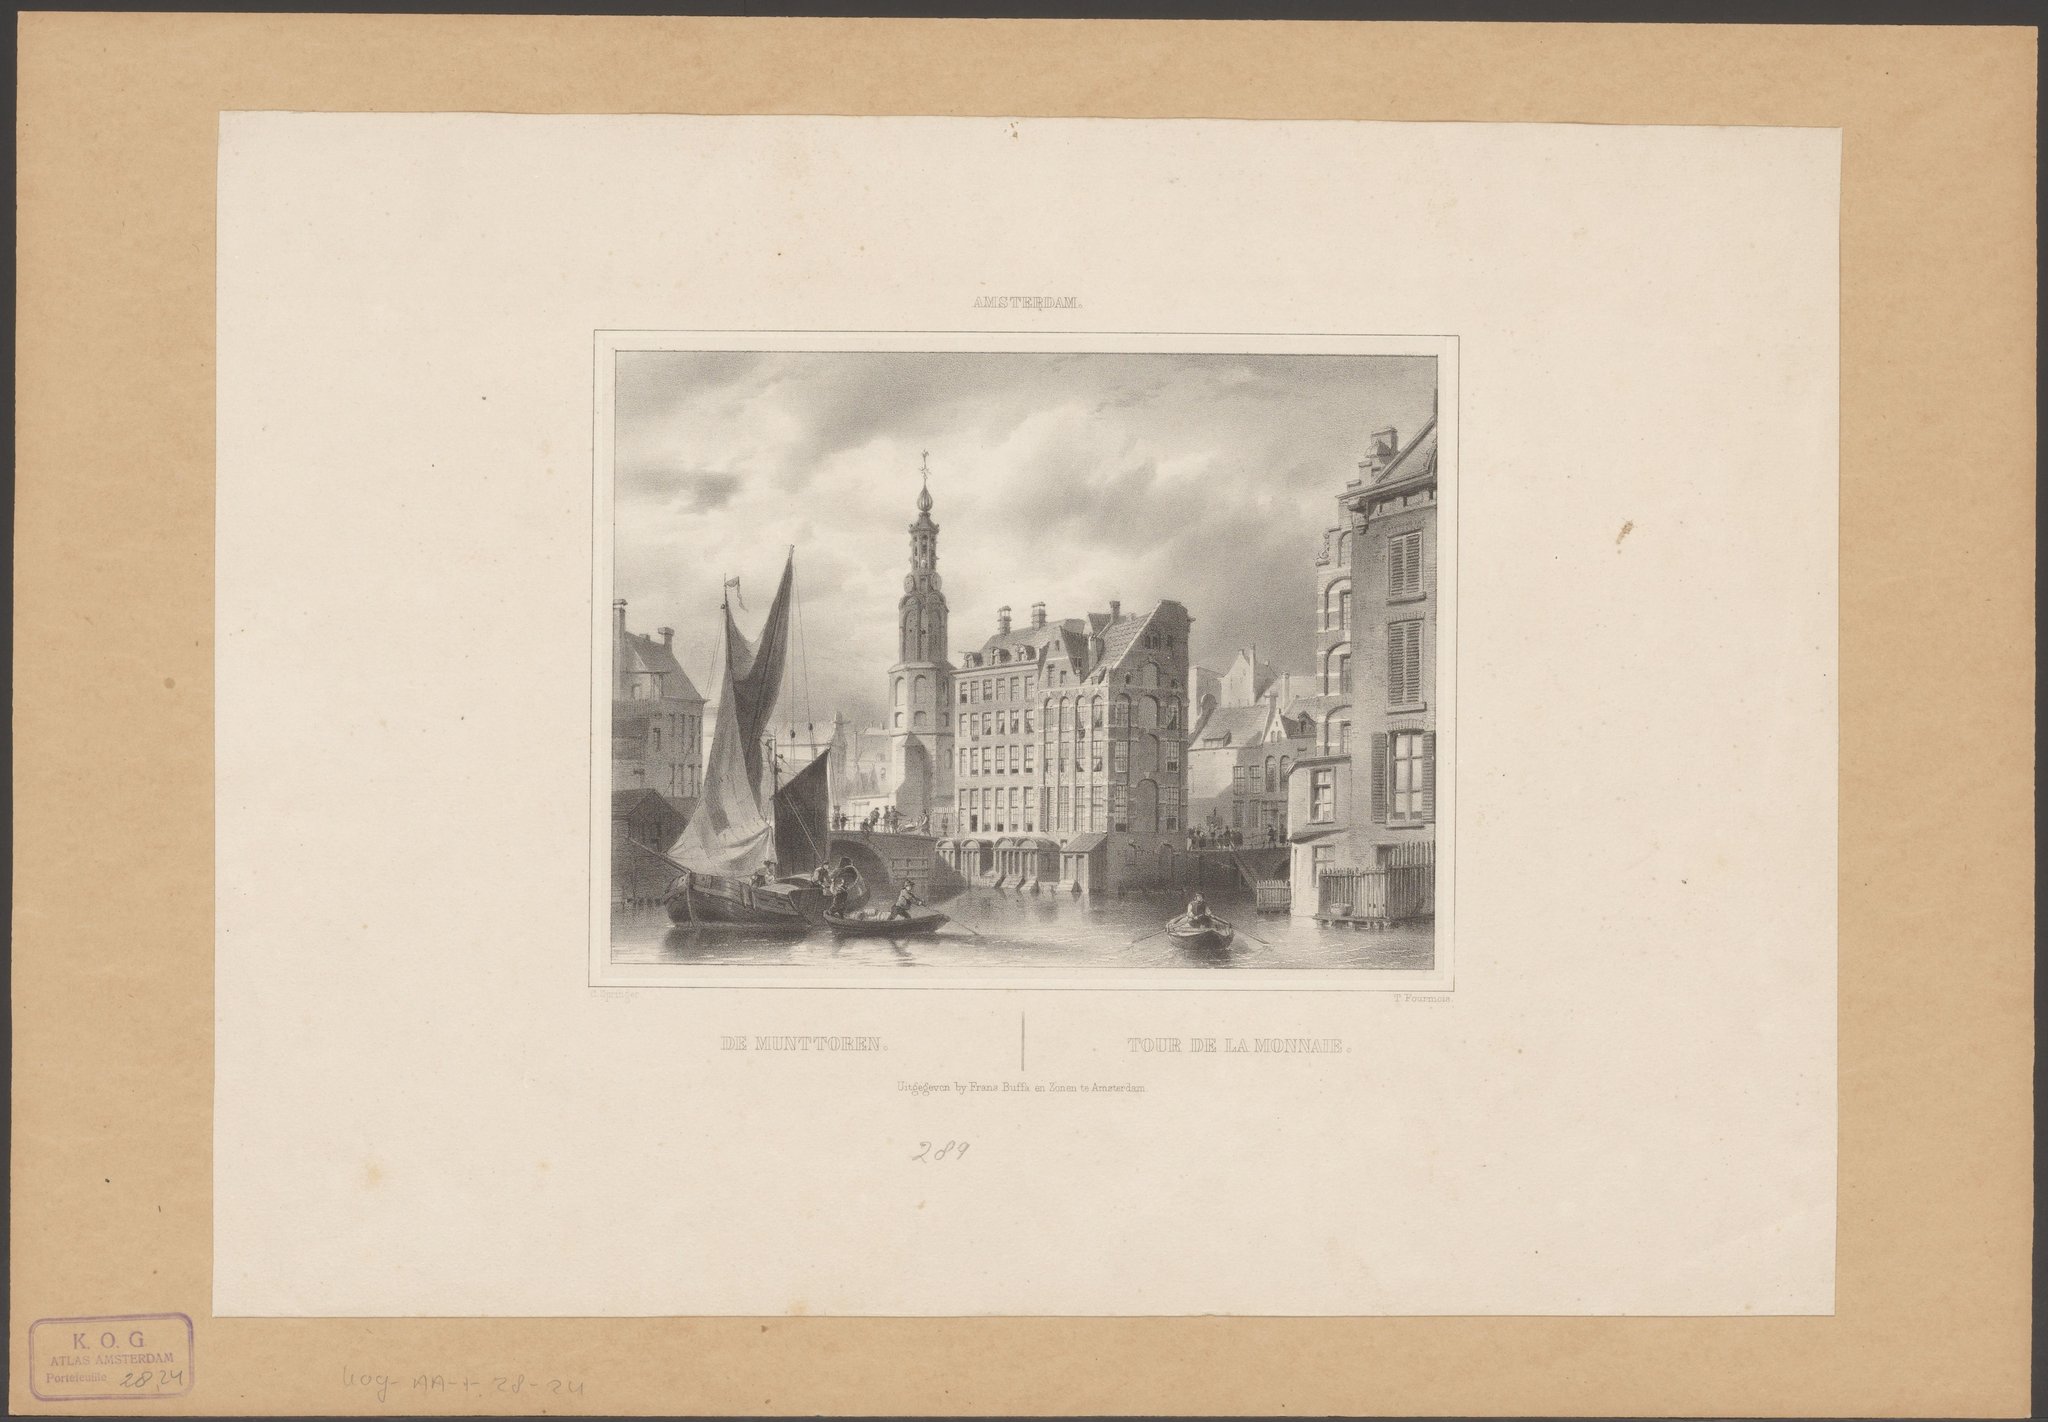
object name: print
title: De Munttoren / Tour de la Monnaie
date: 1824-1871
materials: paper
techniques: lithograph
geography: amsterdam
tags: tower, clock tower ~ monumental adornment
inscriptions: collector's mark: Lugt 1641b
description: Onderwerpsrubriek binnen de Atlas Amsterdam: Poorten, verzamelbladen, B. Regulierspoort(en).